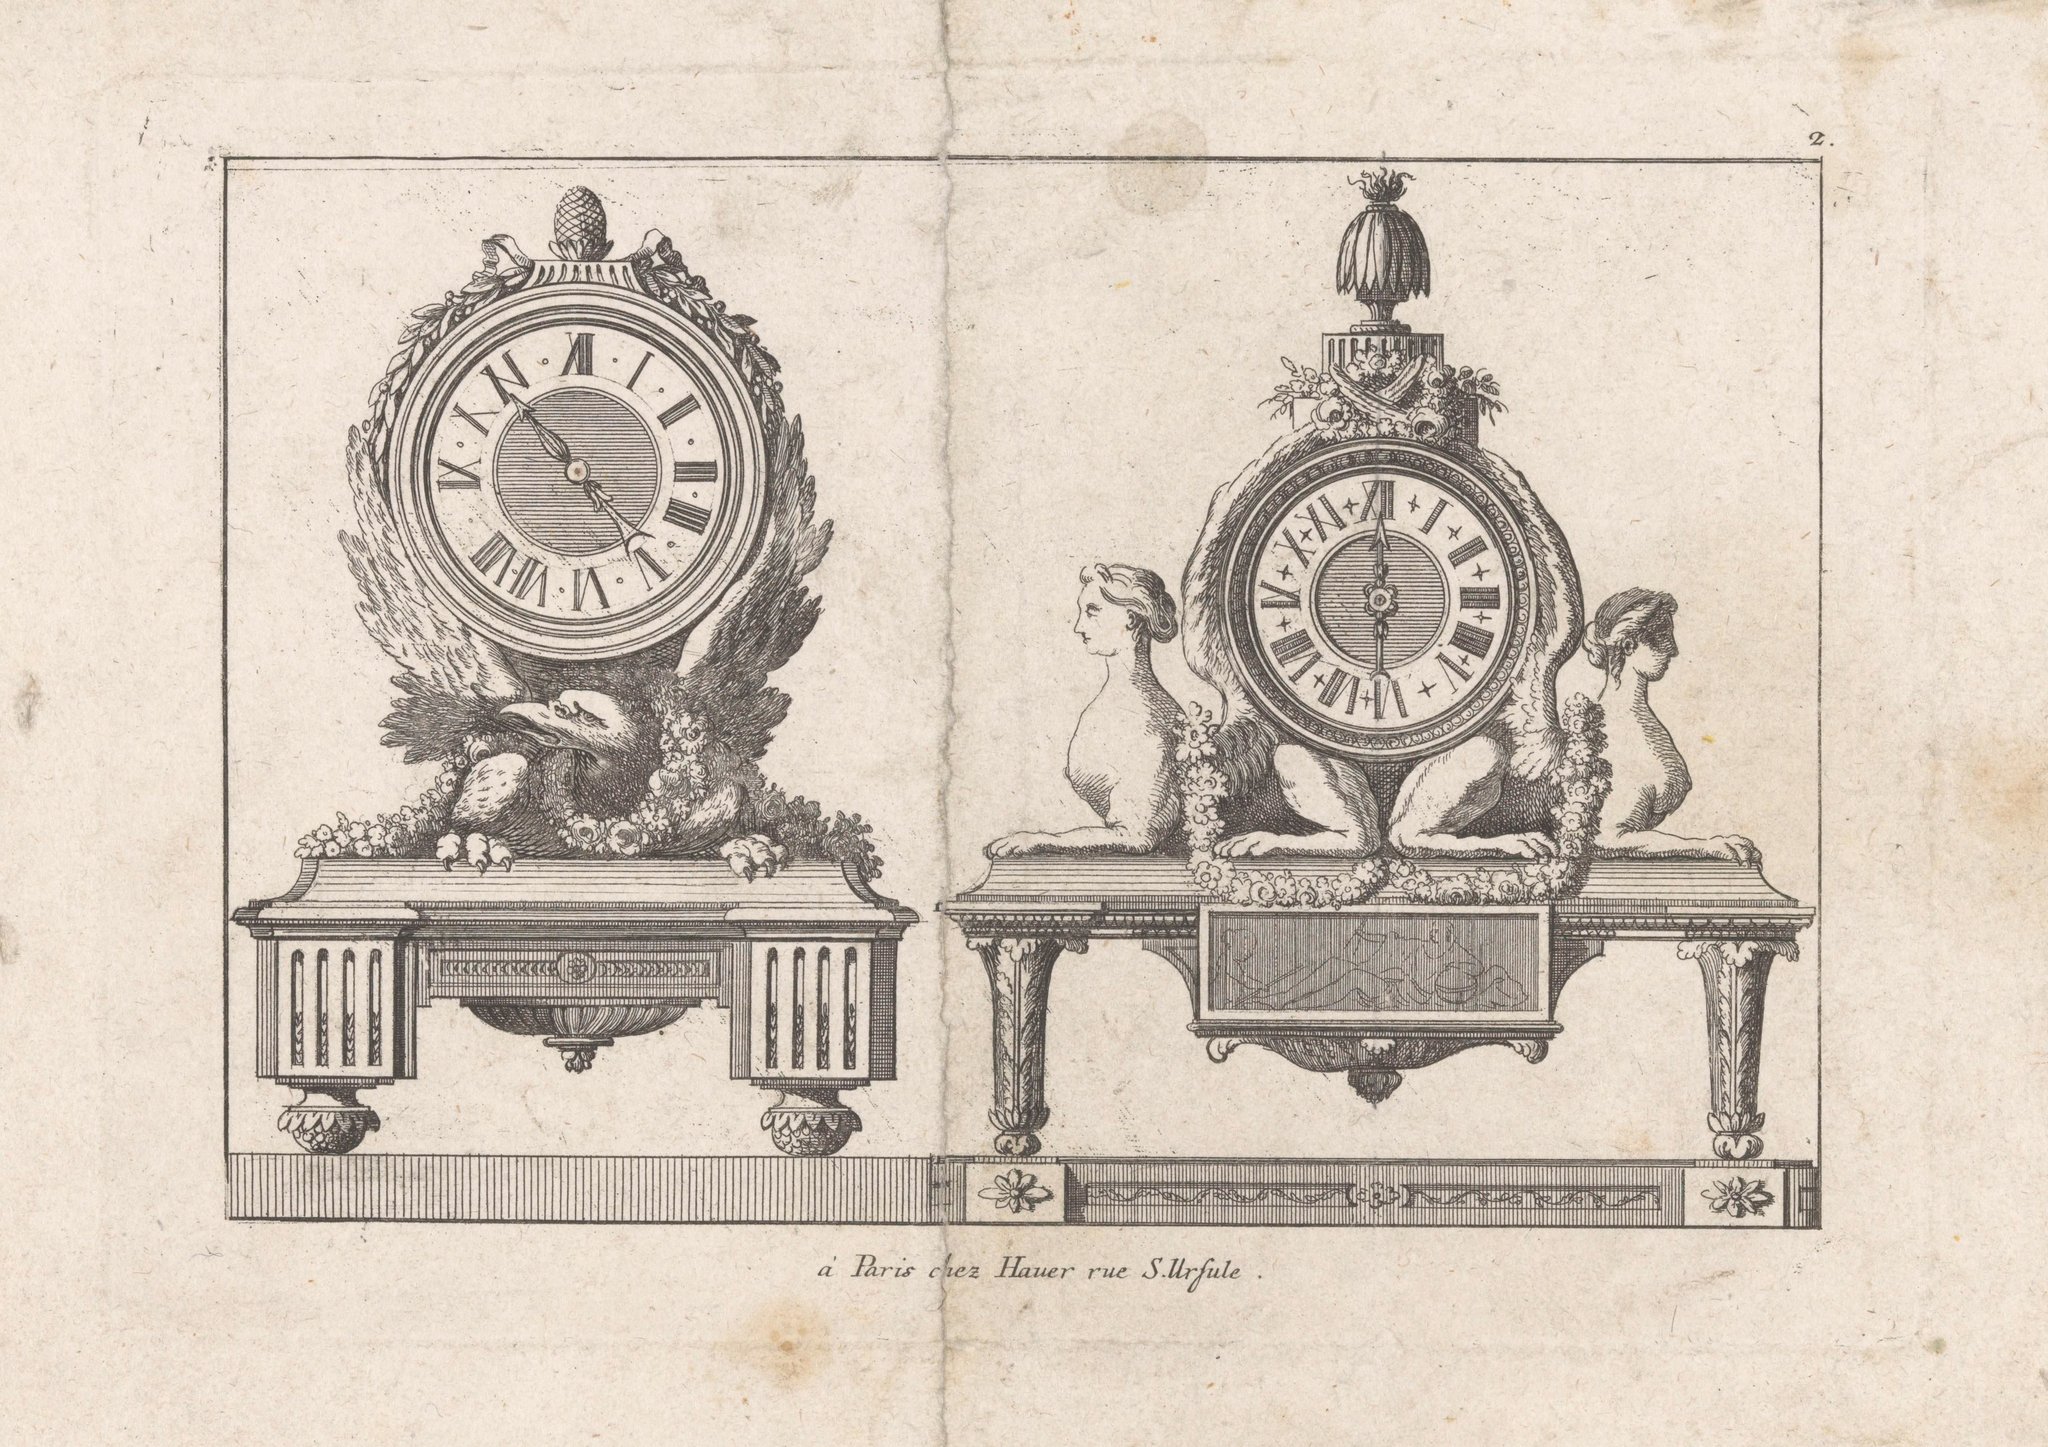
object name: print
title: Twee pendules met adelaar en sfinxen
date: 1758-1820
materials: paper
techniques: engraving, etching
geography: paris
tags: sphinx (lion/woman); 'sfinge' (ripa) - aa - female human figure, predatory birds: eagle, clock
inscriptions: collector's mark: Lugt 2228, collector's mark: Lugt 2760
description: Ontwerpen voor twee pendules. De pendule links wordt gedragen door een adelaar. Rechts dragen twee sfinxen de pendule.